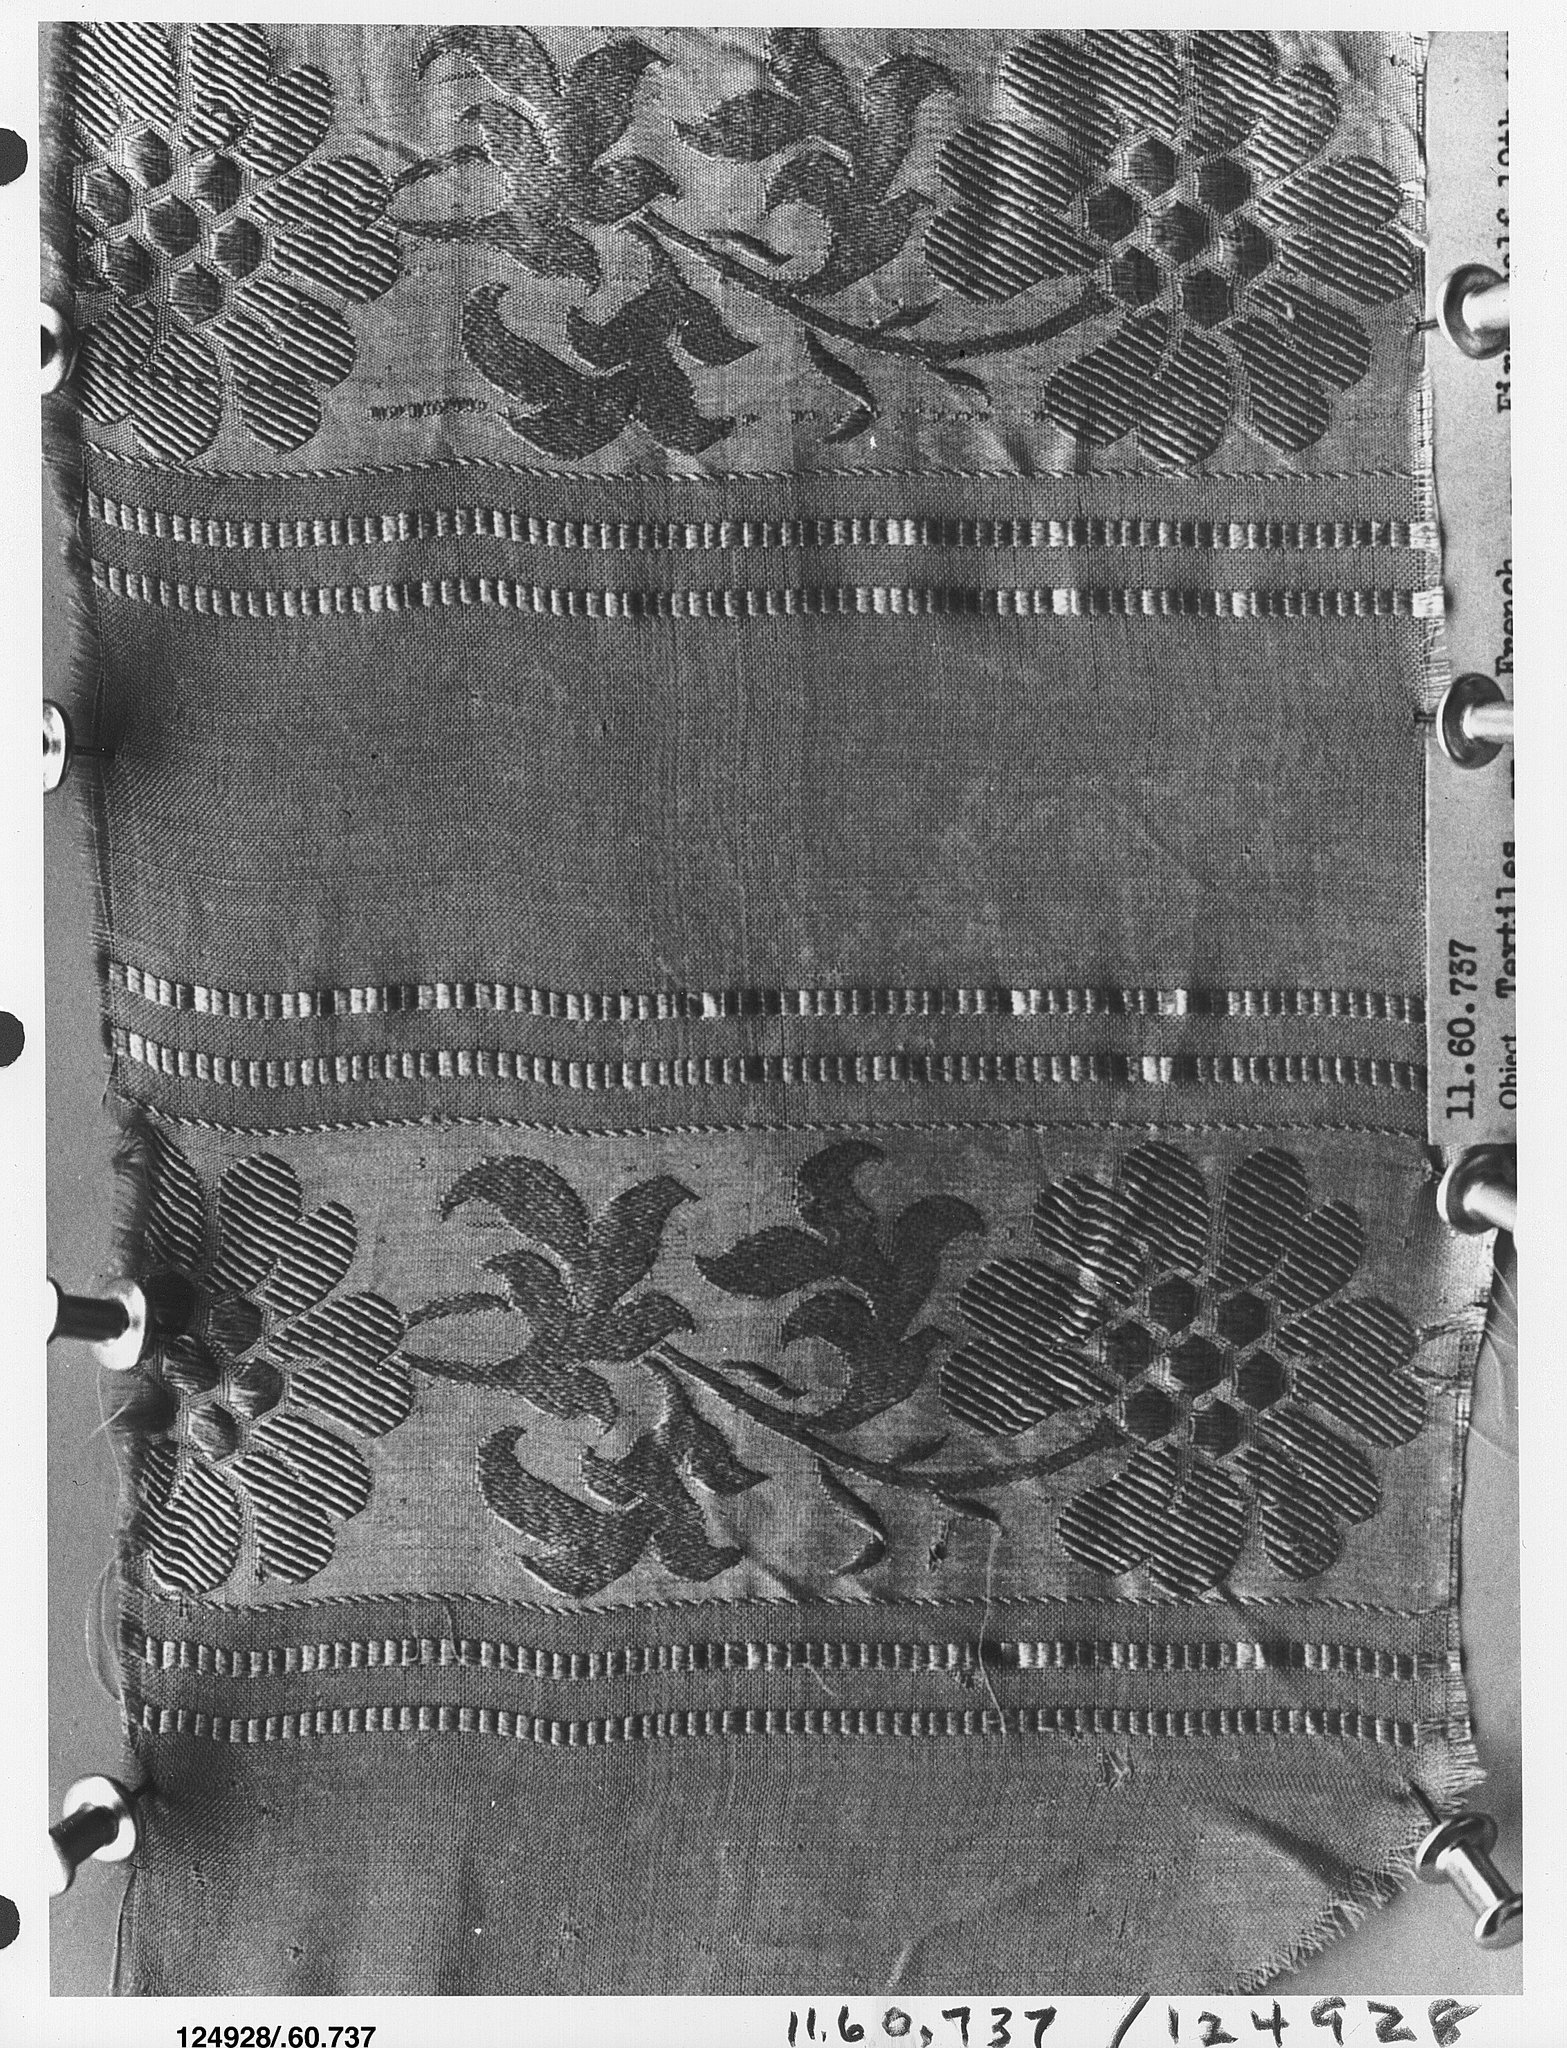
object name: sample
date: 1801-1850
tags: flowers